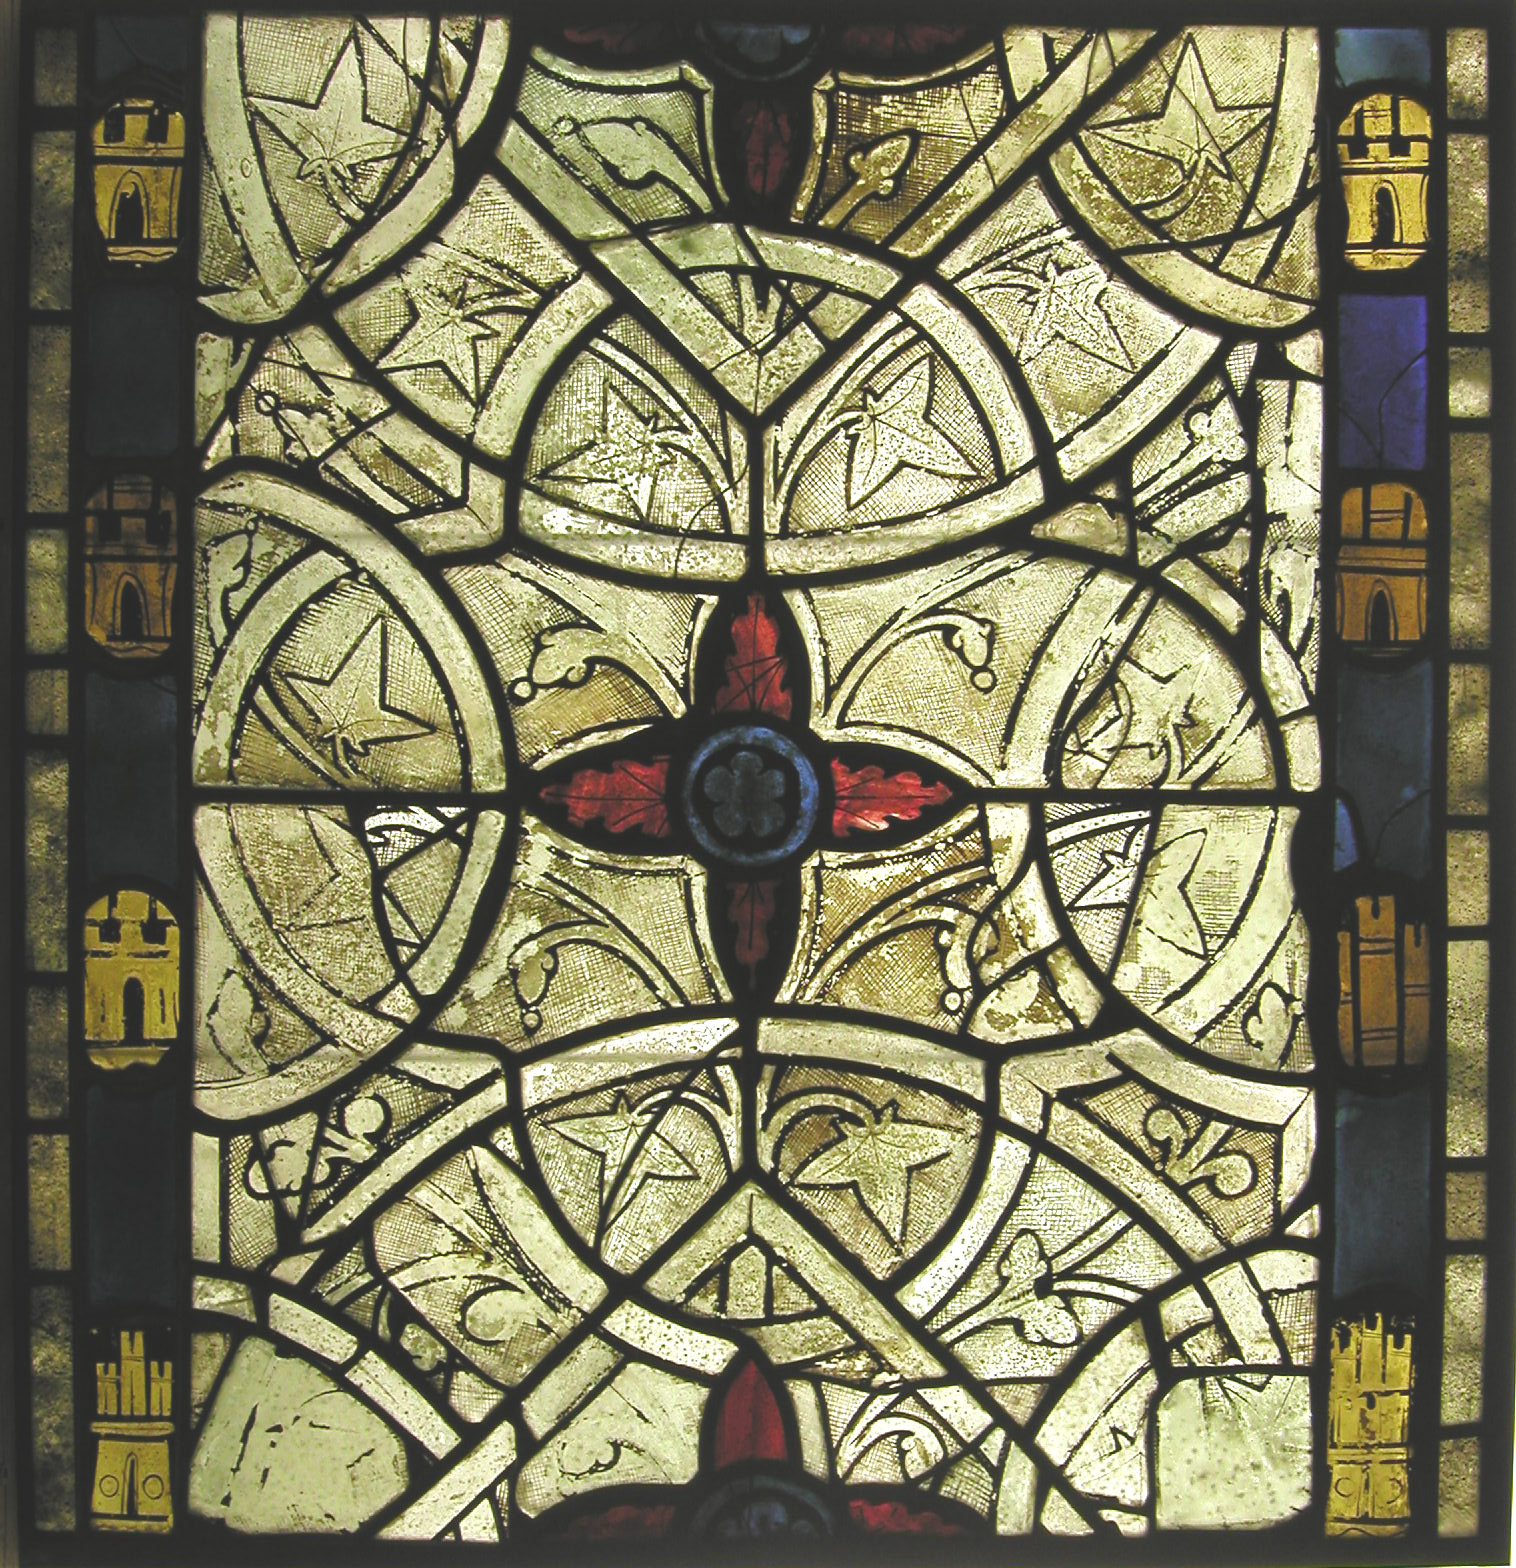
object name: panel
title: Grisaille Panel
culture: french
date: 1265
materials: glass, metal, paint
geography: france